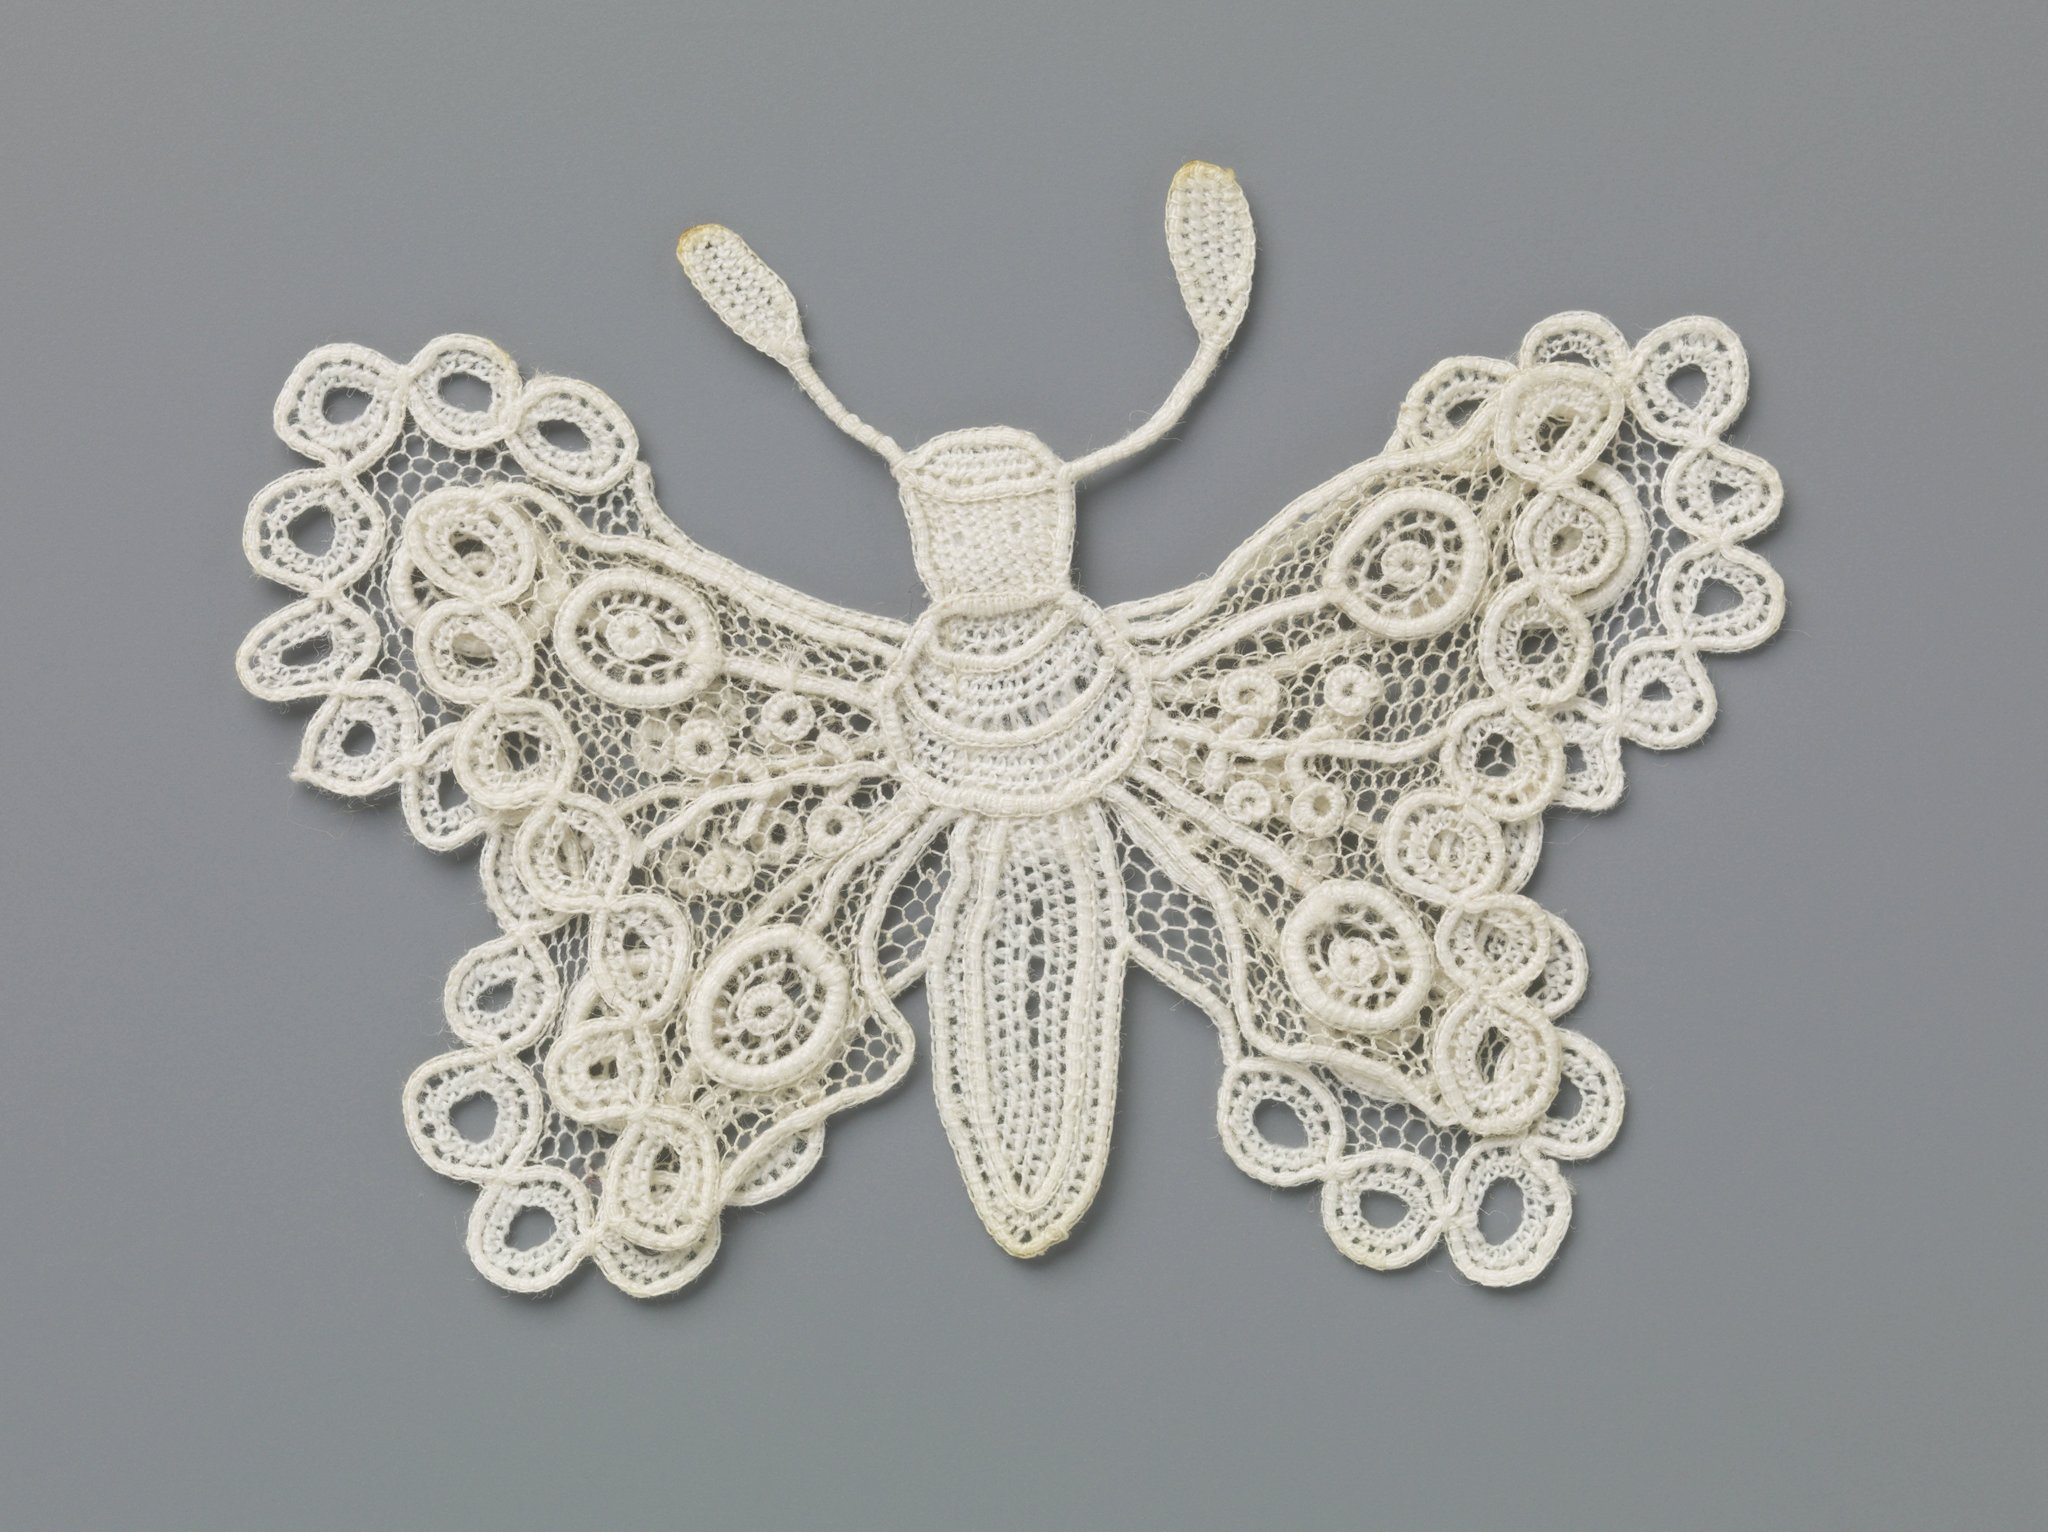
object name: applicatie textiel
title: Applicatie van Brussels naaldkant in de vorm van een vlinder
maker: Anonymous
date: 1900-1914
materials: linen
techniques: lace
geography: belgium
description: Applicatie van naturelkleurige Brusselse naaldkant, in de vorm van een vlinder. Het lijf van de vlinder is dichtgewerkt, de dubbele vleugels zijn afgezet met open cirkels en versierd met gestileerde bloemen. De vlinder behoort tot een serie van in totaal 4 objecten waarin de ontwikkeling om te komen tot dit eindproduct gedemonstreerd worden.